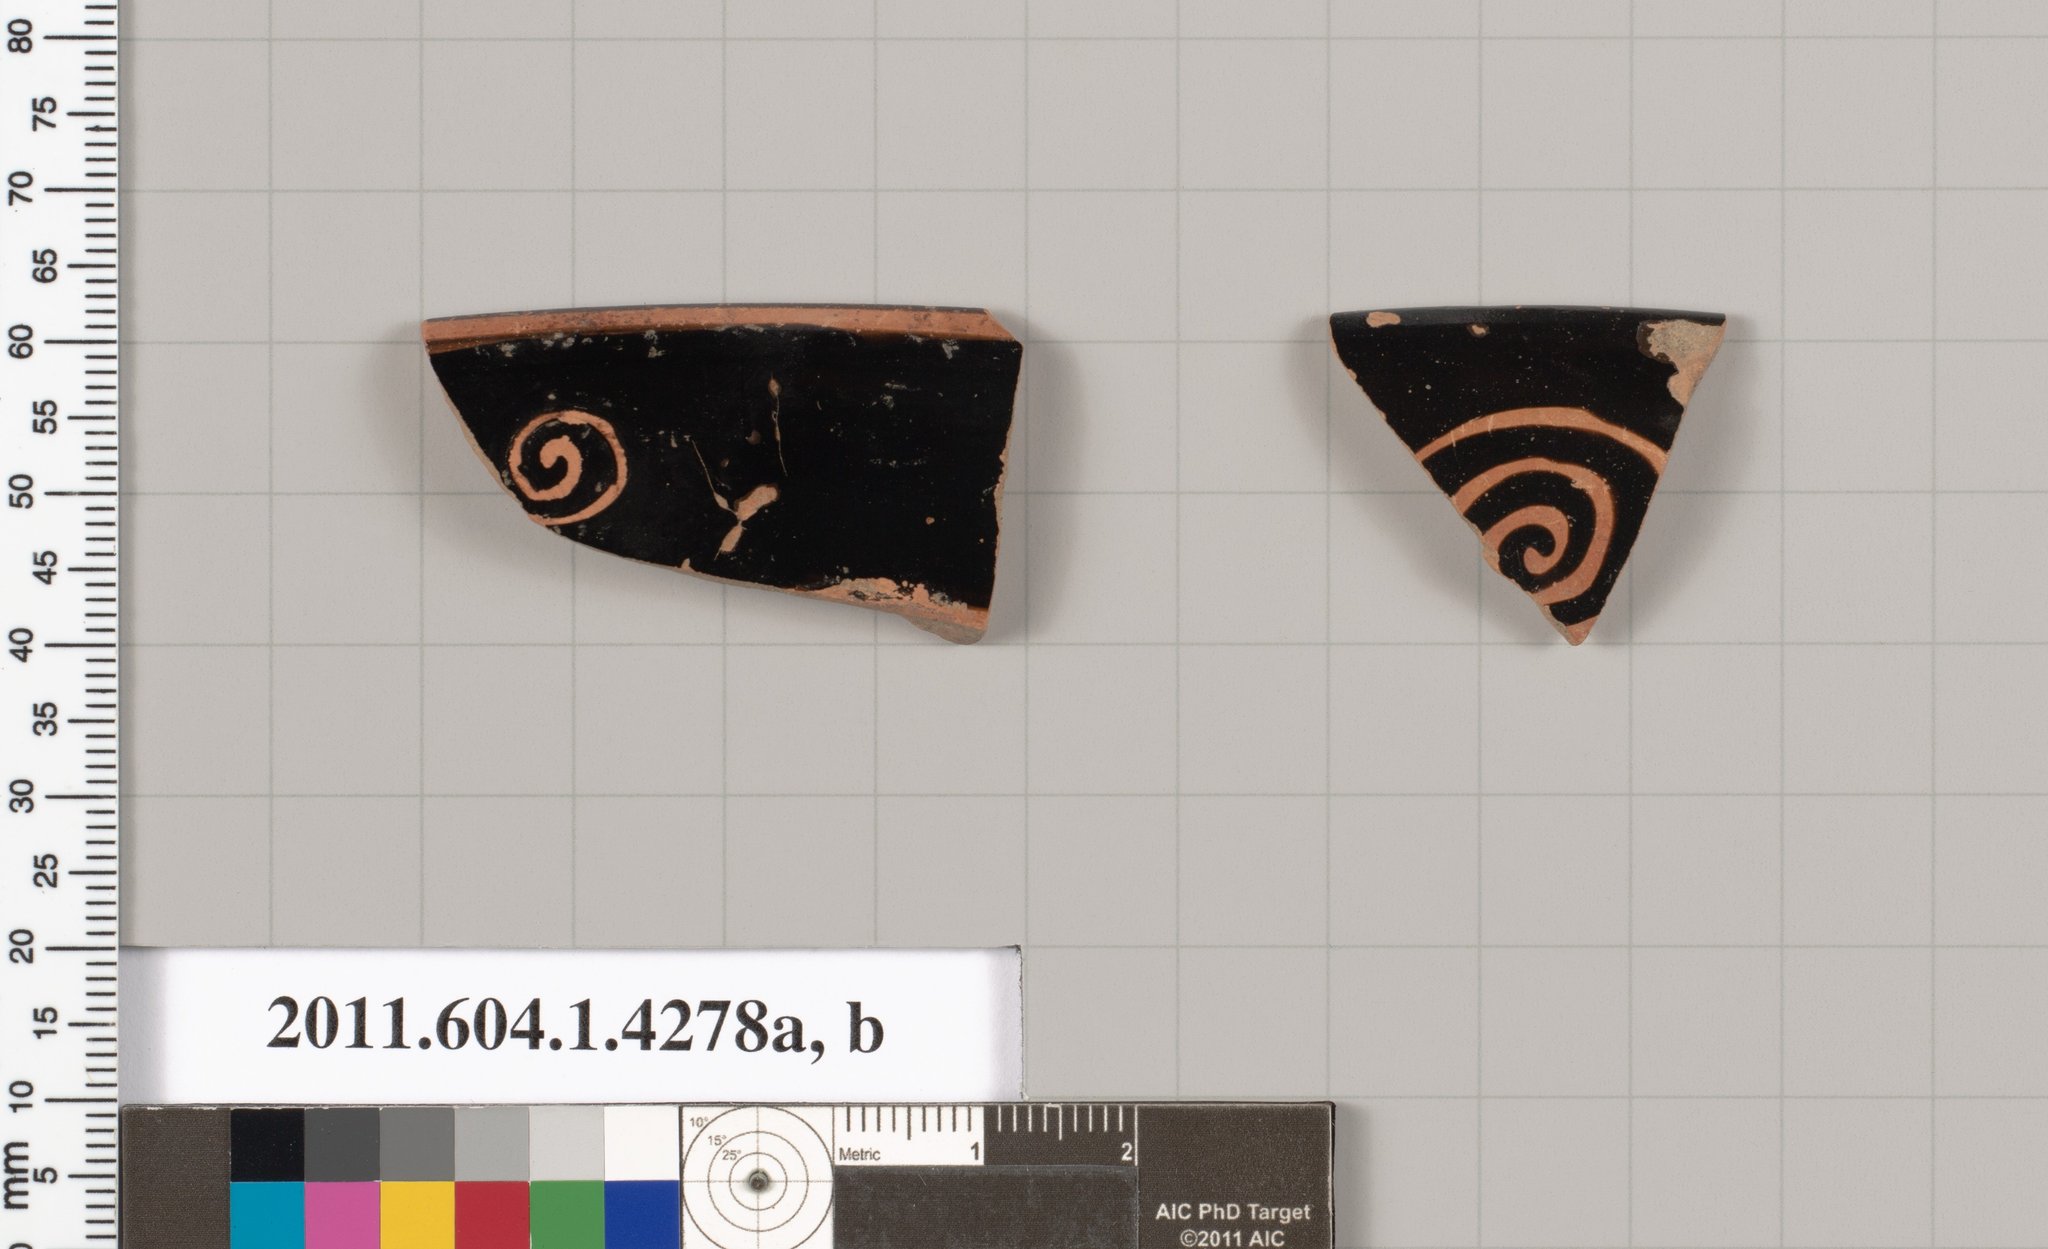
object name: kylix fragment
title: Terracotta rim fragments of kylikes (drinking cups)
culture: greek, attic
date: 500-451 BCE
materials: terracotta